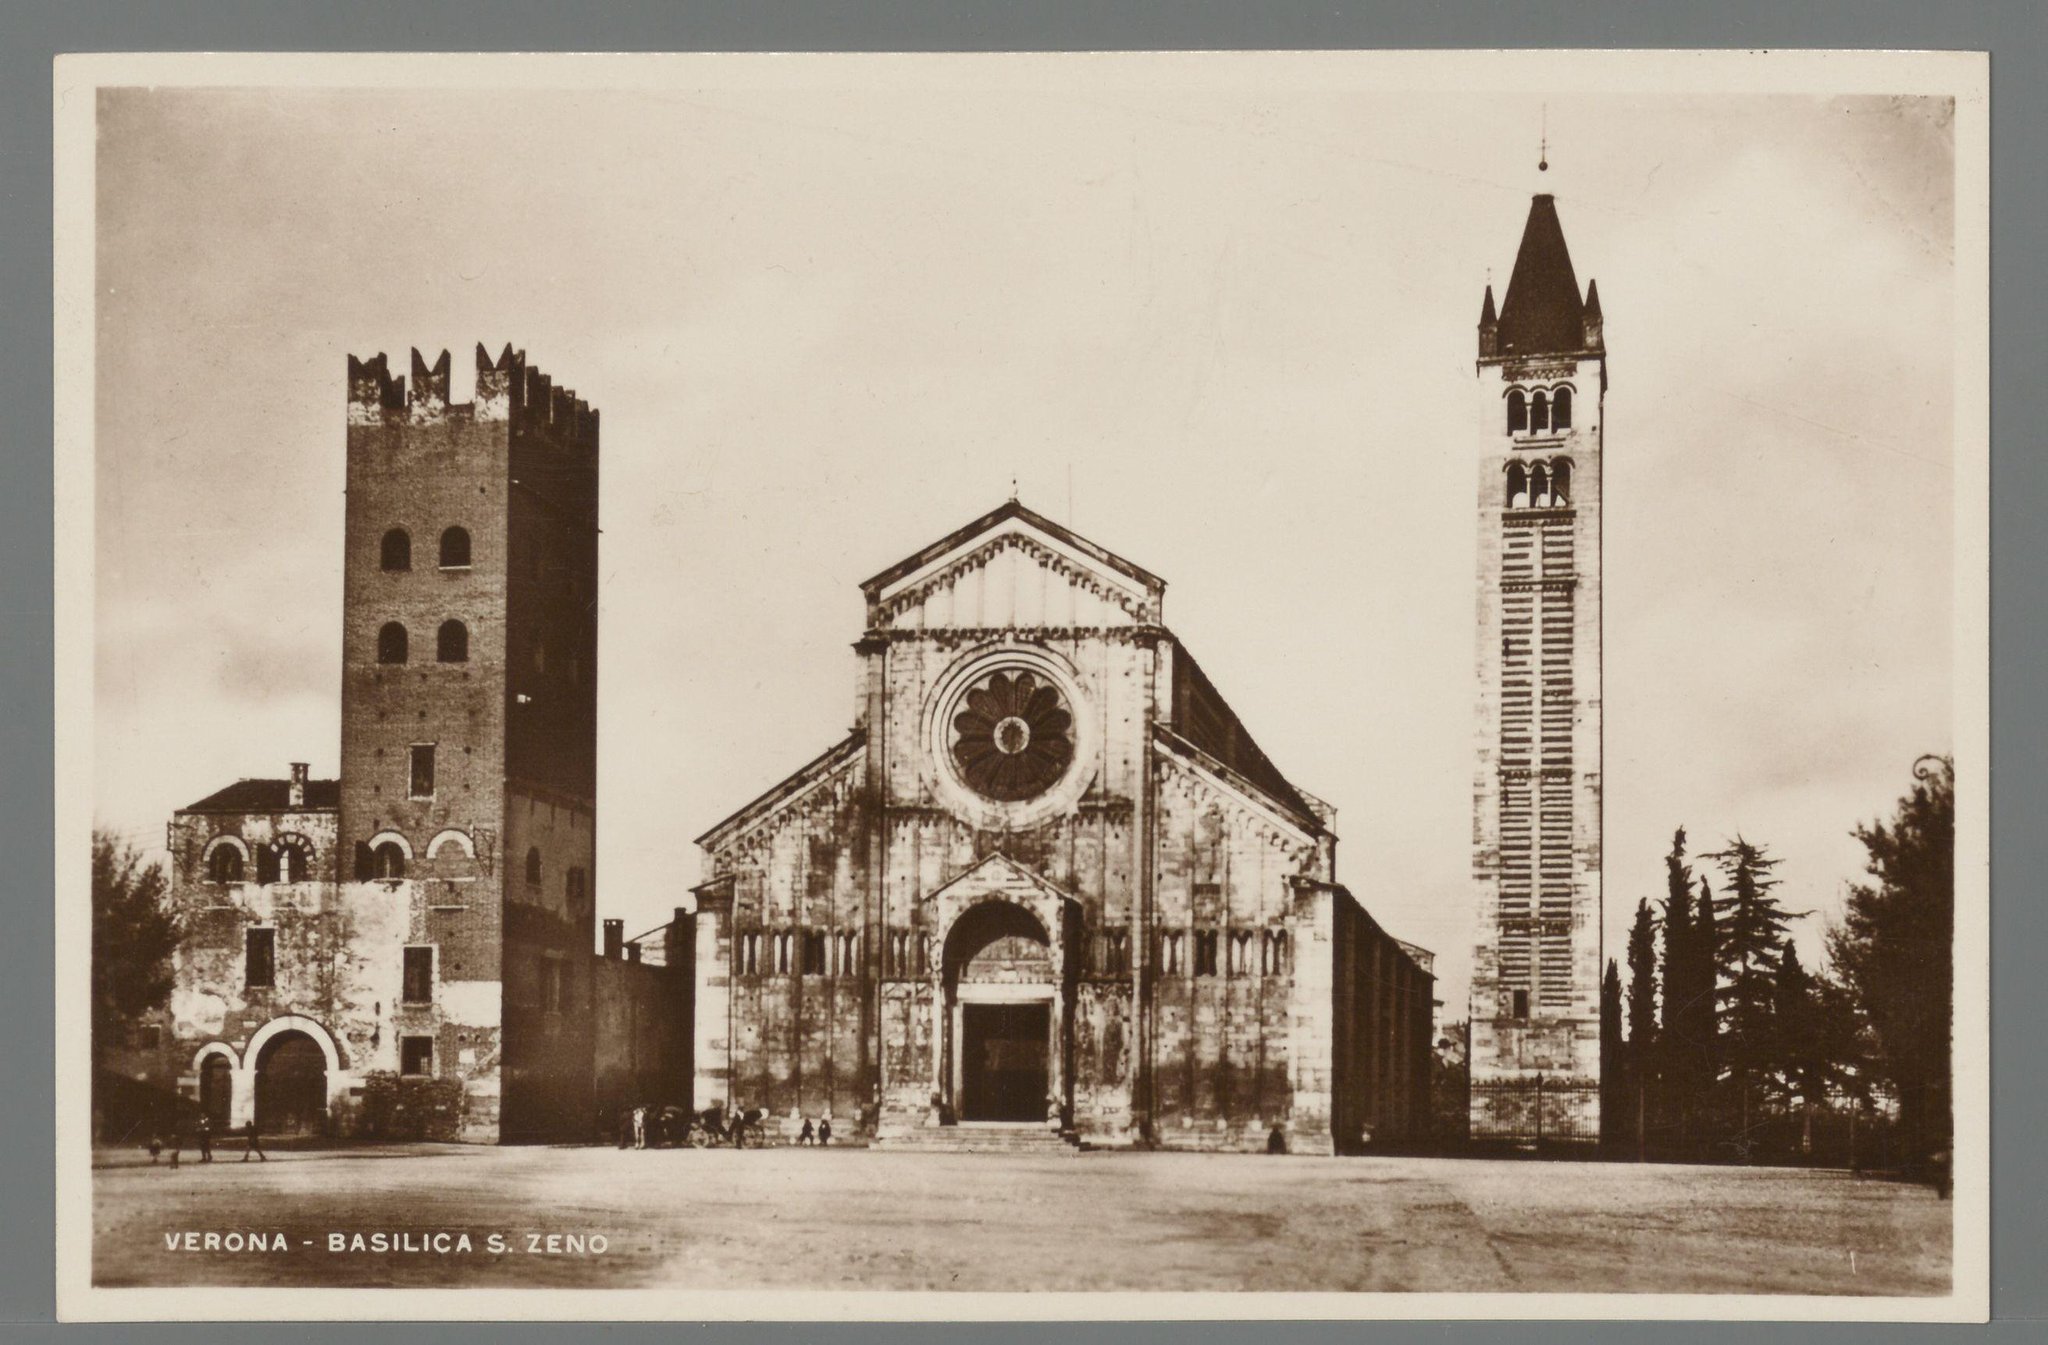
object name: ansichtkaart, prentbriefkaart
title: Verona. Basilica S. Zeno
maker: Anonymous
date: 1930-1950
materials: photographic support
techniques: photography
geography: turin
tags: church (exterior), square, place, circus, etc. (+ city(-scape) with figures, staffage)